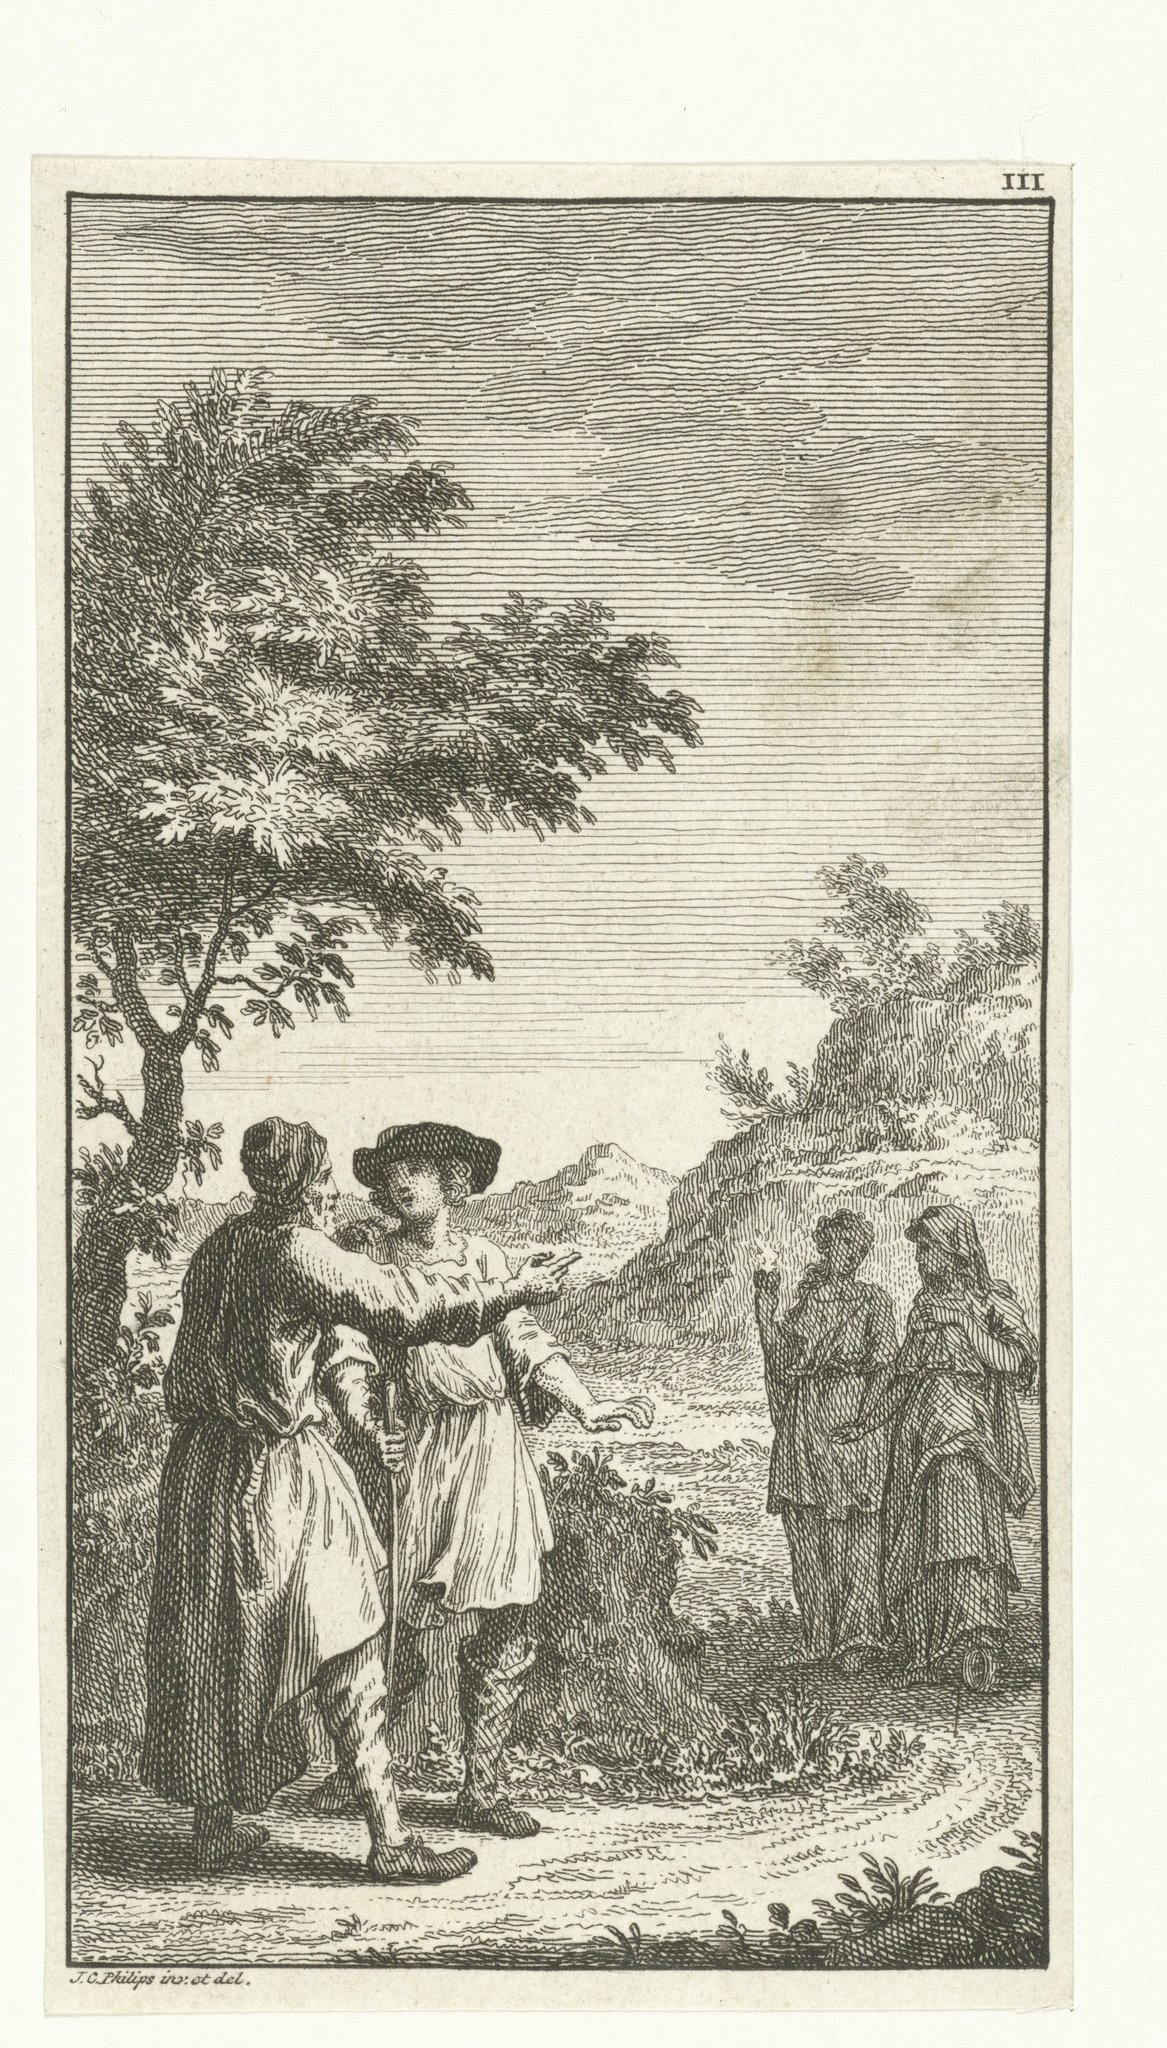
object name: print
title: Bospad met een oude man die een jonge man de weg wijst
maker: jan caspar philips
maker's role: draughtsman, print maker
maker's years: 1700-1775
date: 1736-1775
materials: paper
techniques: engraving, etching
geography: amsterdam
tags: justitia (justice) as roman personification, love: 'frau minne' and other allegories, asking the way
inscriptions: collector's mark: Lugt 2228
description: Bospad met een oude man die een jonge man de weg wijst. Op de achtergrond komen de personificatie van de Liefde, met een brandend hart in de hand, en de personificatie van Rechtvaardigheid, de wandelaar tegemoet. Rechtsboven genummerd: III.